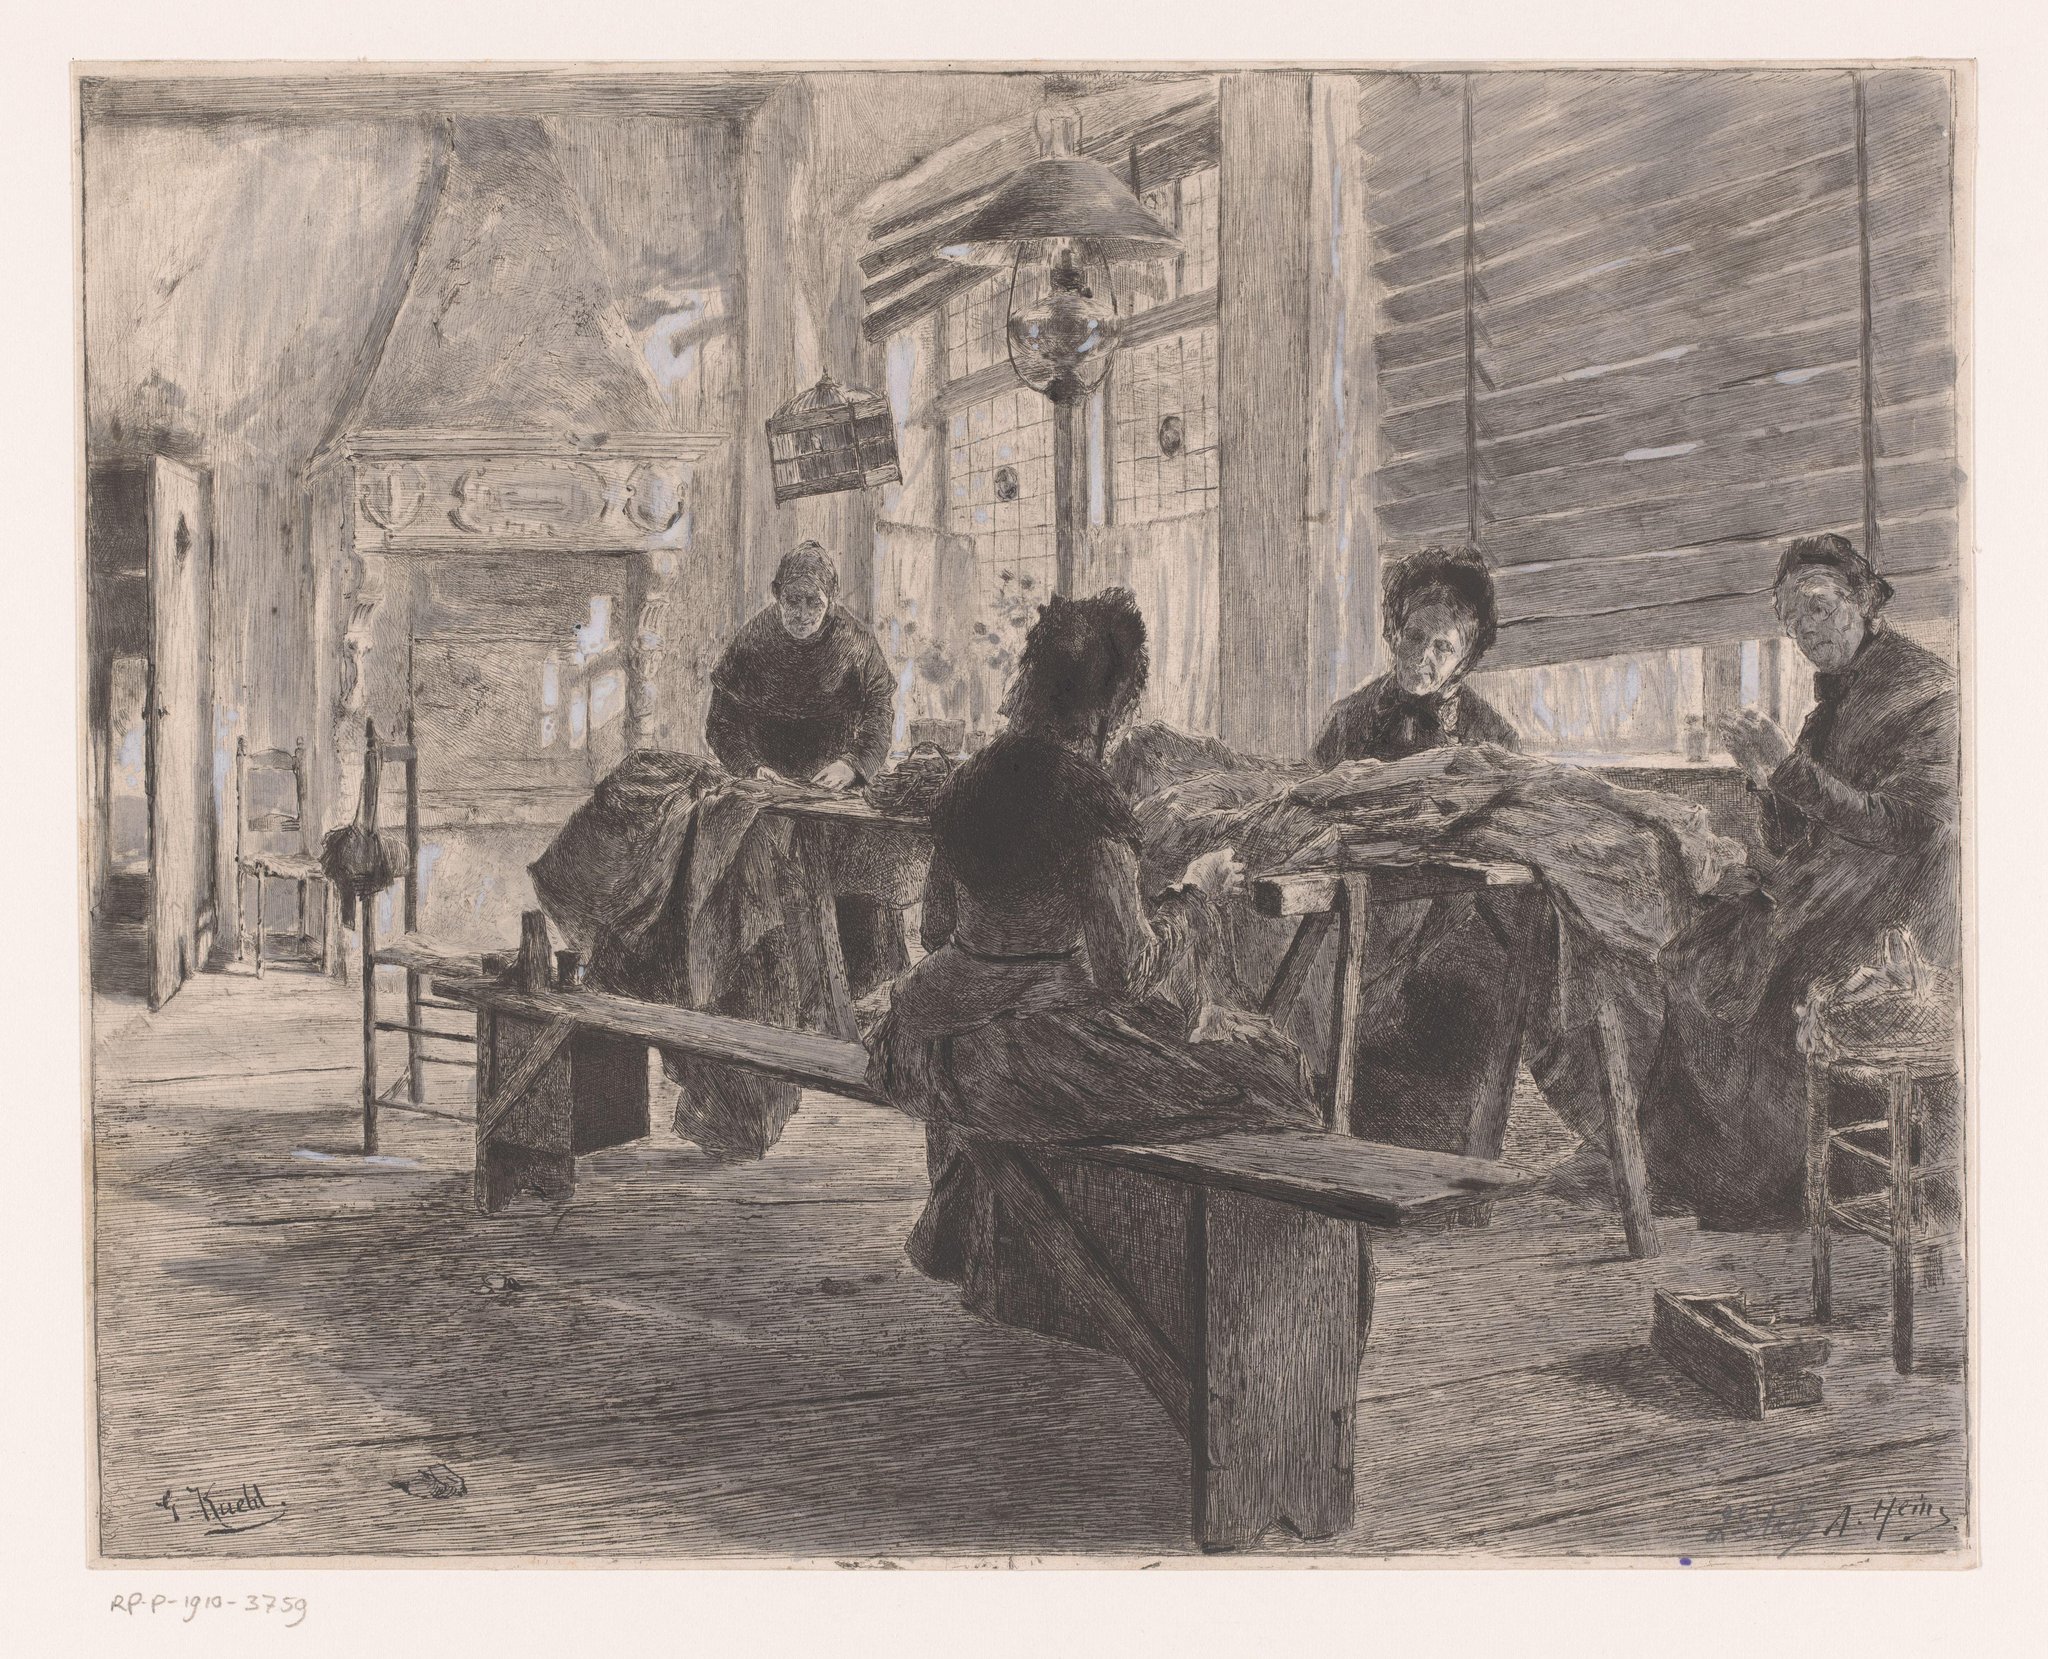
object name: print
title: Vier vrouwen in een naaiatelier aan het werk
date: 1866-1910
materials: paper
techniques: brush, etching, intaglio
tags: workshop-interior, sewing, textile industry and clothing industry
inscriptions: collector's mark: Lugt 2228, inscription: ‘2e état’